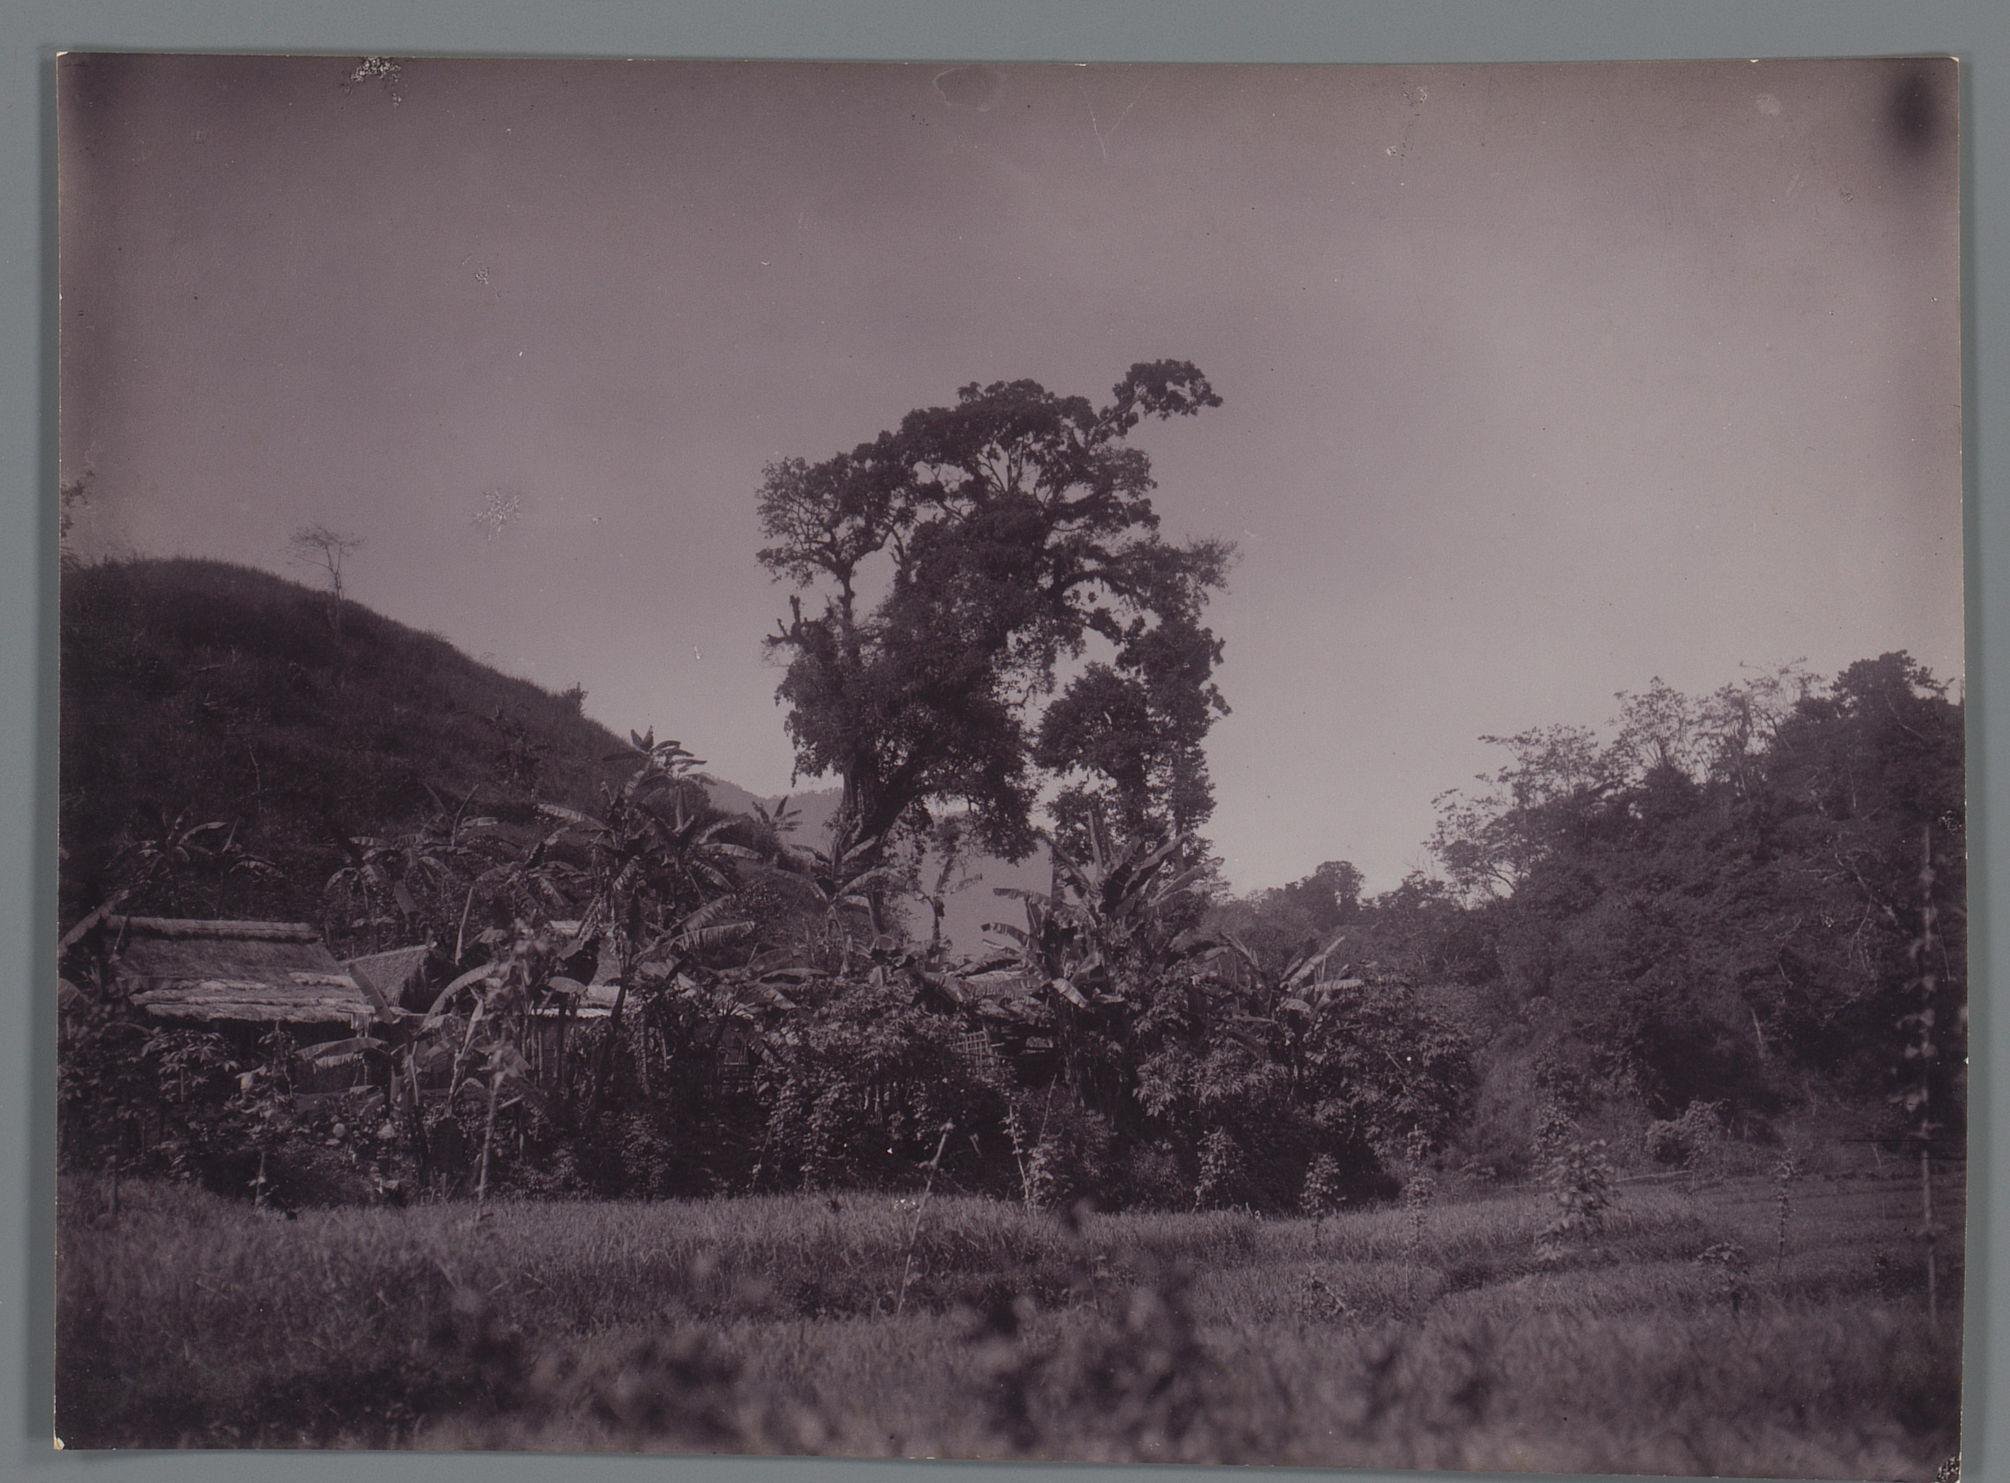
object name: photograph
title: Velden en bomen bij Poedjon, Java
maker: Anonymous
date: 1890-1920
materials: paper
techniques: gelatin silver print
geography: dutch east indies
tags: trees, cultivated land, java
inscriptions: inscription: ‘Gezicht voor de badpl/ van v. Sorgen/ Poedjon’